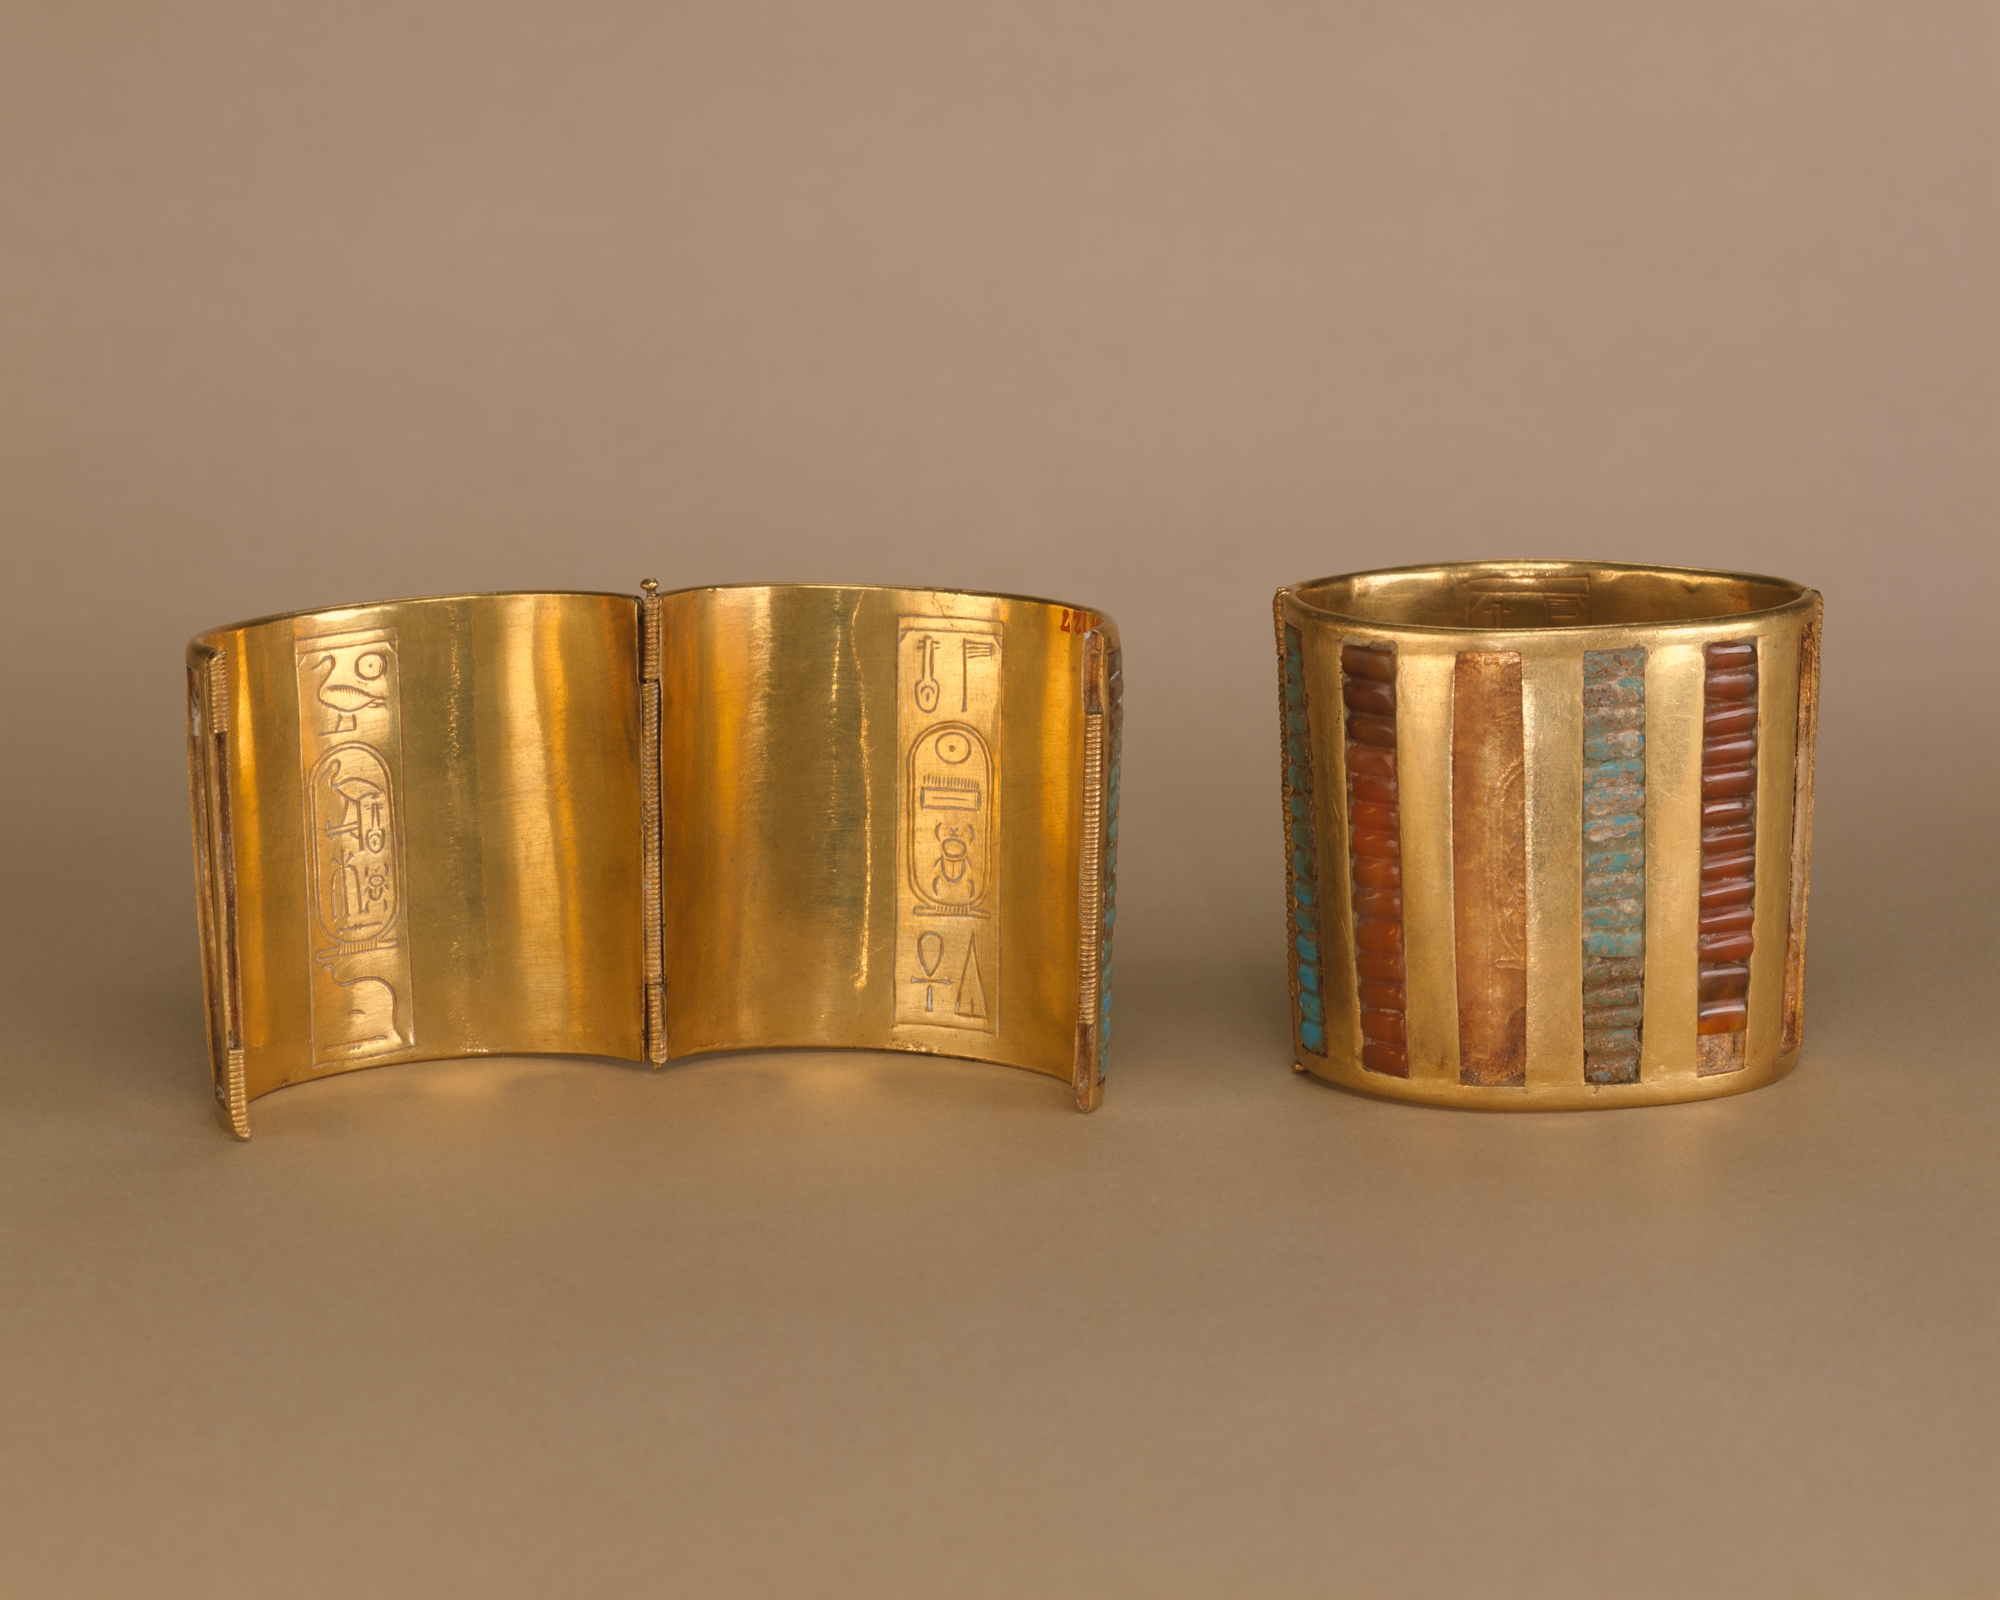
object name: bracelet, cuff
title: Hinged Cuff Bracelet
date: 1479-1425 BCE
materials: gemstone, glass, gold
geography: egypt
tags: hieroglyphs